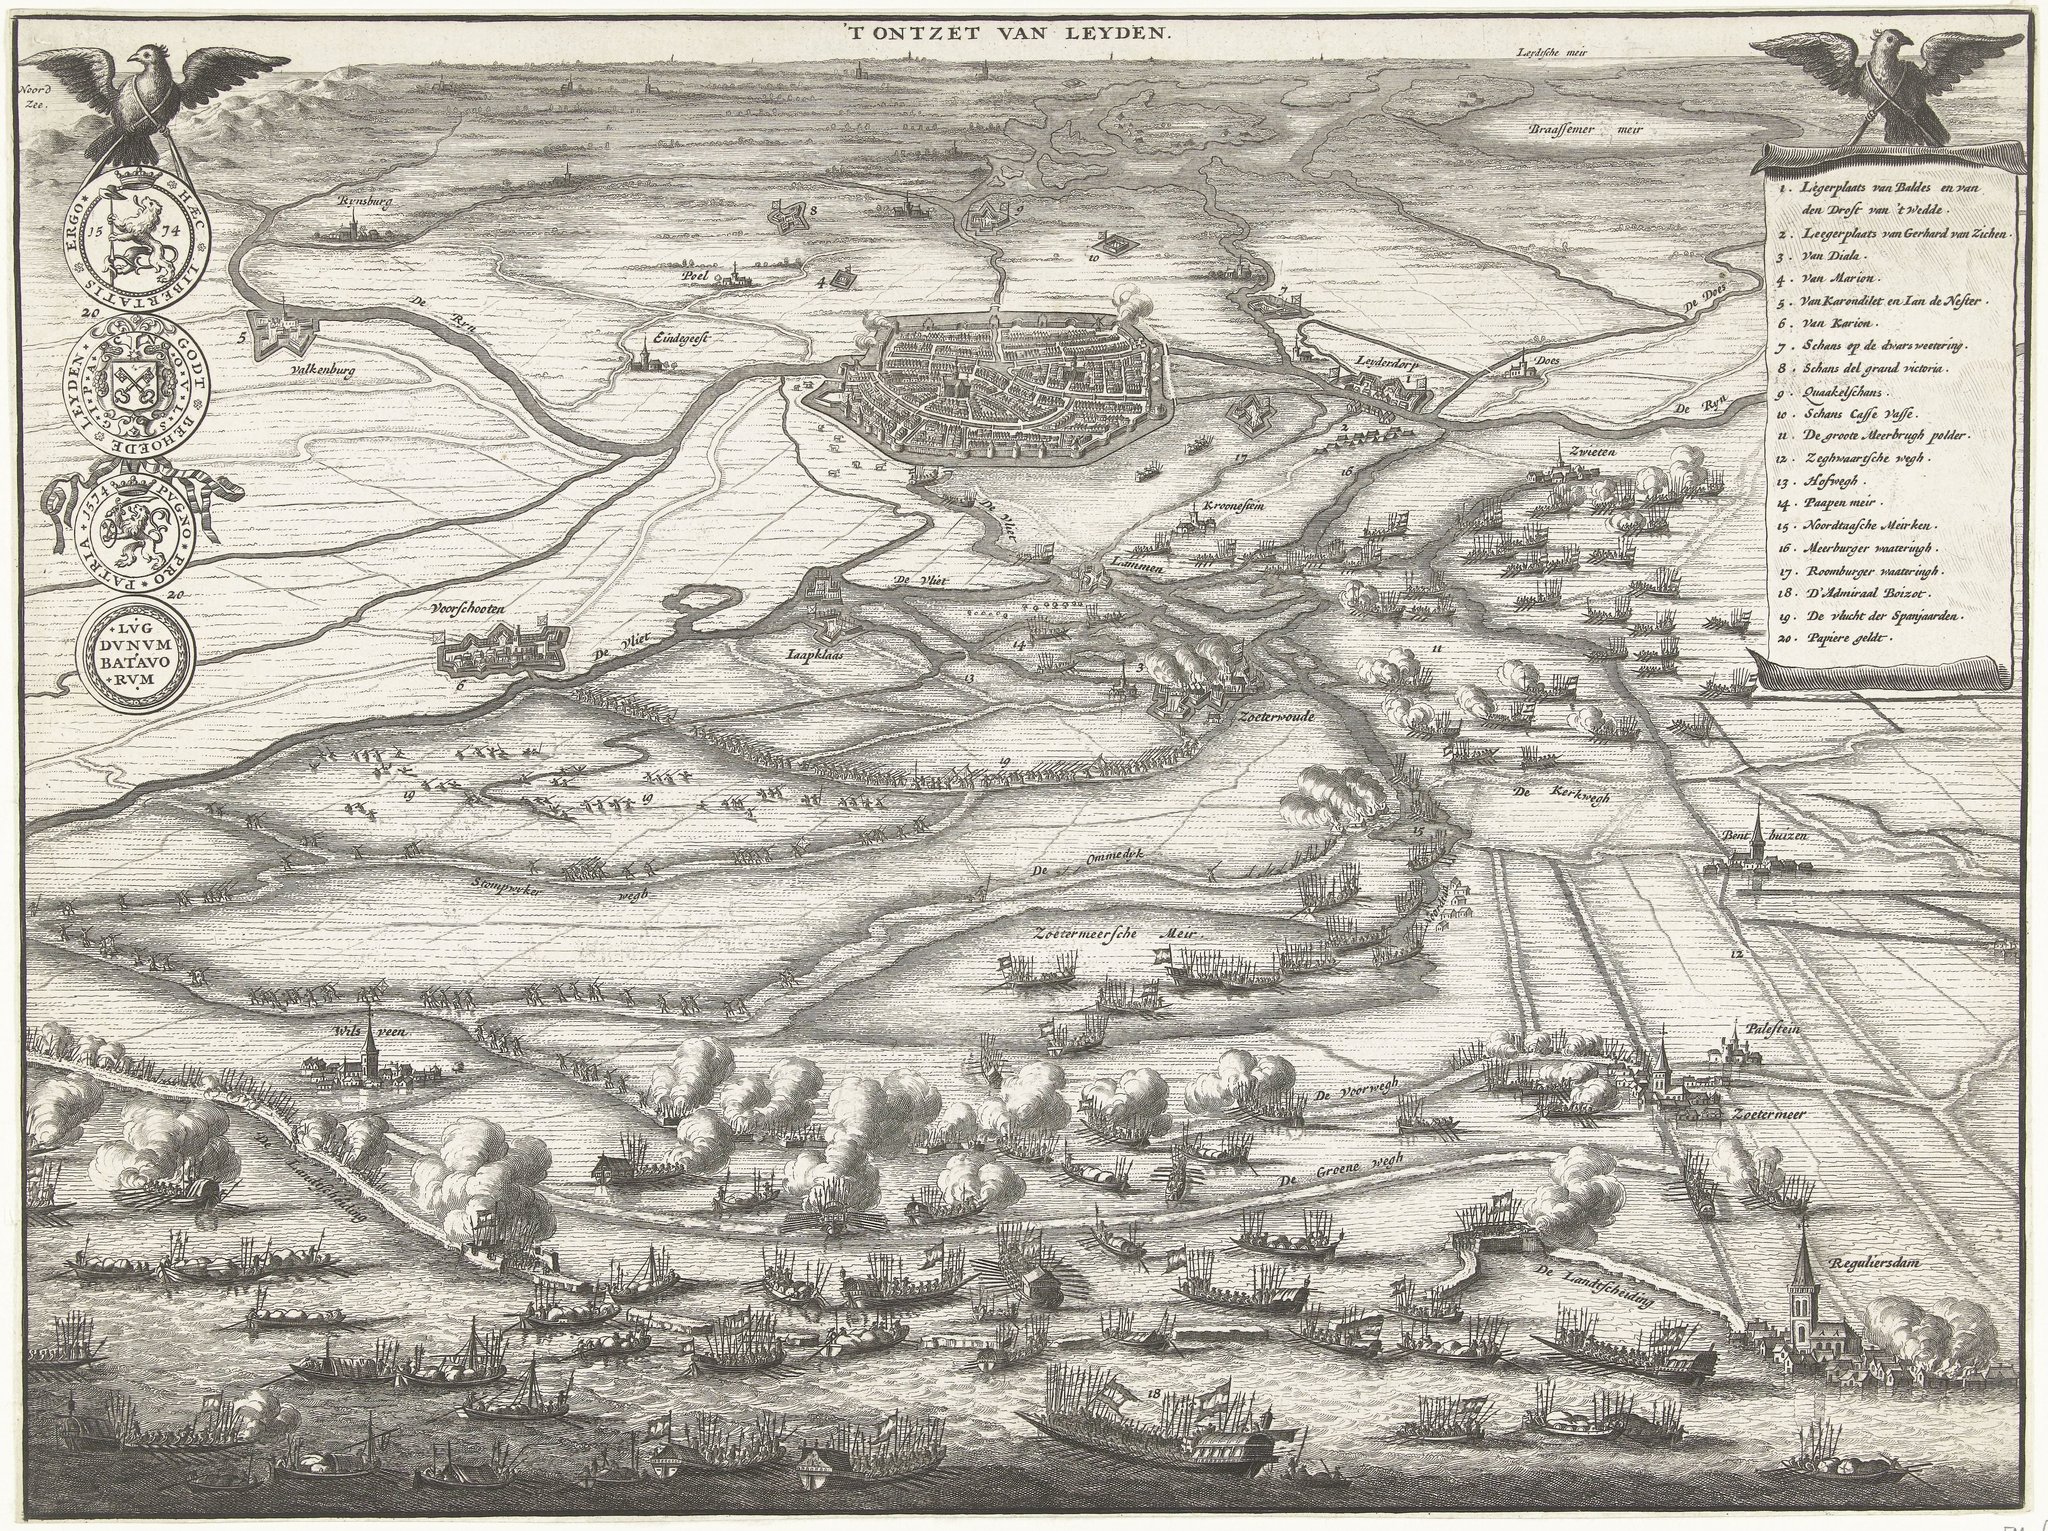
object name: map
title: Kaart met het ontzet van Leiden, 1574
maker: coenraet decker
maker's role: print maker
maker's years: 1650-1685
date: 1703-1730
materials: paper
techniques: etching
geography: amsterdam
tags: raising the siege with outside assistance, relief, maps of separate countries or regions, battle, leiden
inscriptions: collector's mark: Lugt 240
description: Eerdere staat ook gebruikt in: Goris, Johan. Hugo de Groots Nederlandtsche Jaerboeken en Historien. Amsterdam: weduwe Johan van Someren, Abraham Wolfgang en Hendrik en Dirk Boom, 1681, tussen p. 48 en 49. En in: P.C. Hoofts Nederlandsche historien, seedert de ooverdraght der heerschappye van kaizar Karel den Vyfden op koning Philips zynen zoon, tot het einde der landtvooghdye des graven van Leicester. 4e druk. 2 delen. Amsterdam: Hendrik Wetstein en Pieter Sceperus, Leiden: Daniel van den Dalen en Utrecht: Willem van de Water, 1703, dl. 1, tussen p. 394 en 395. Latere staat ook gebruikt in: Clerc, Jean le. Geschiedenissen der Vereenigde Nederlanden, sedert den aanvang van die Republyk tot op den Vrede van Utrecht in 't jaar 1713 (…). 3 delen. Amsterdam: Zacharias Chatelain, 1730, dl. 1, tussen p. 60 en 61.